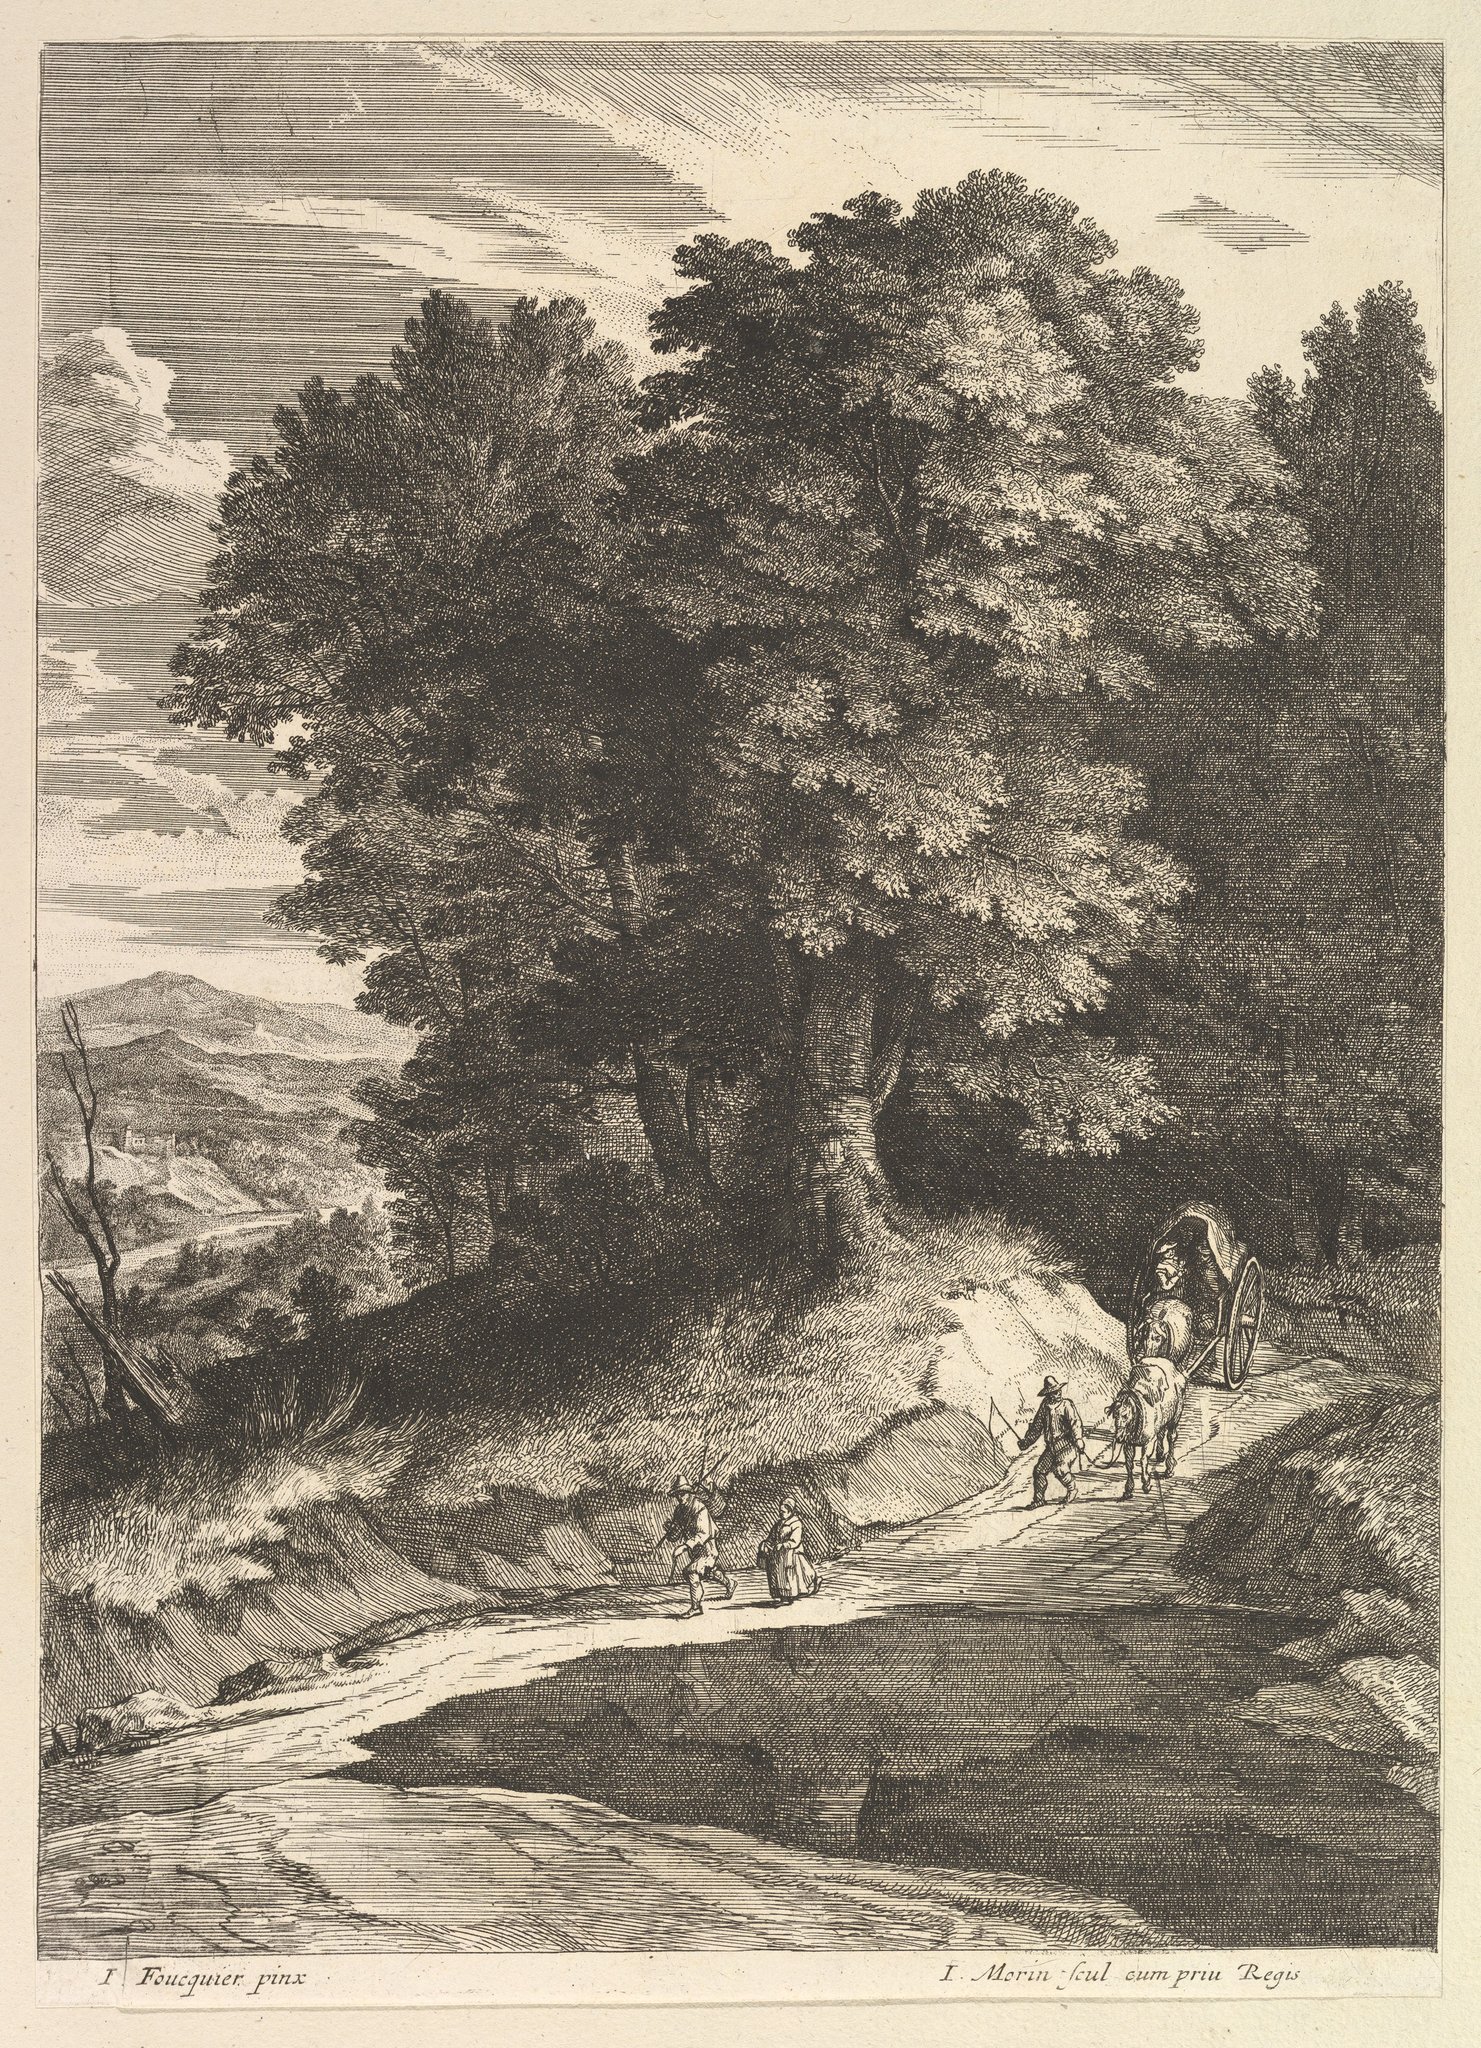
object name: print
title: Le Chariot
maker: jean morin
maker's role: artist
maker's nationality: french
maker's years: 1605-1650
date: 1605-1650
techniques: etching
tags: human figures,landscapes,wagons